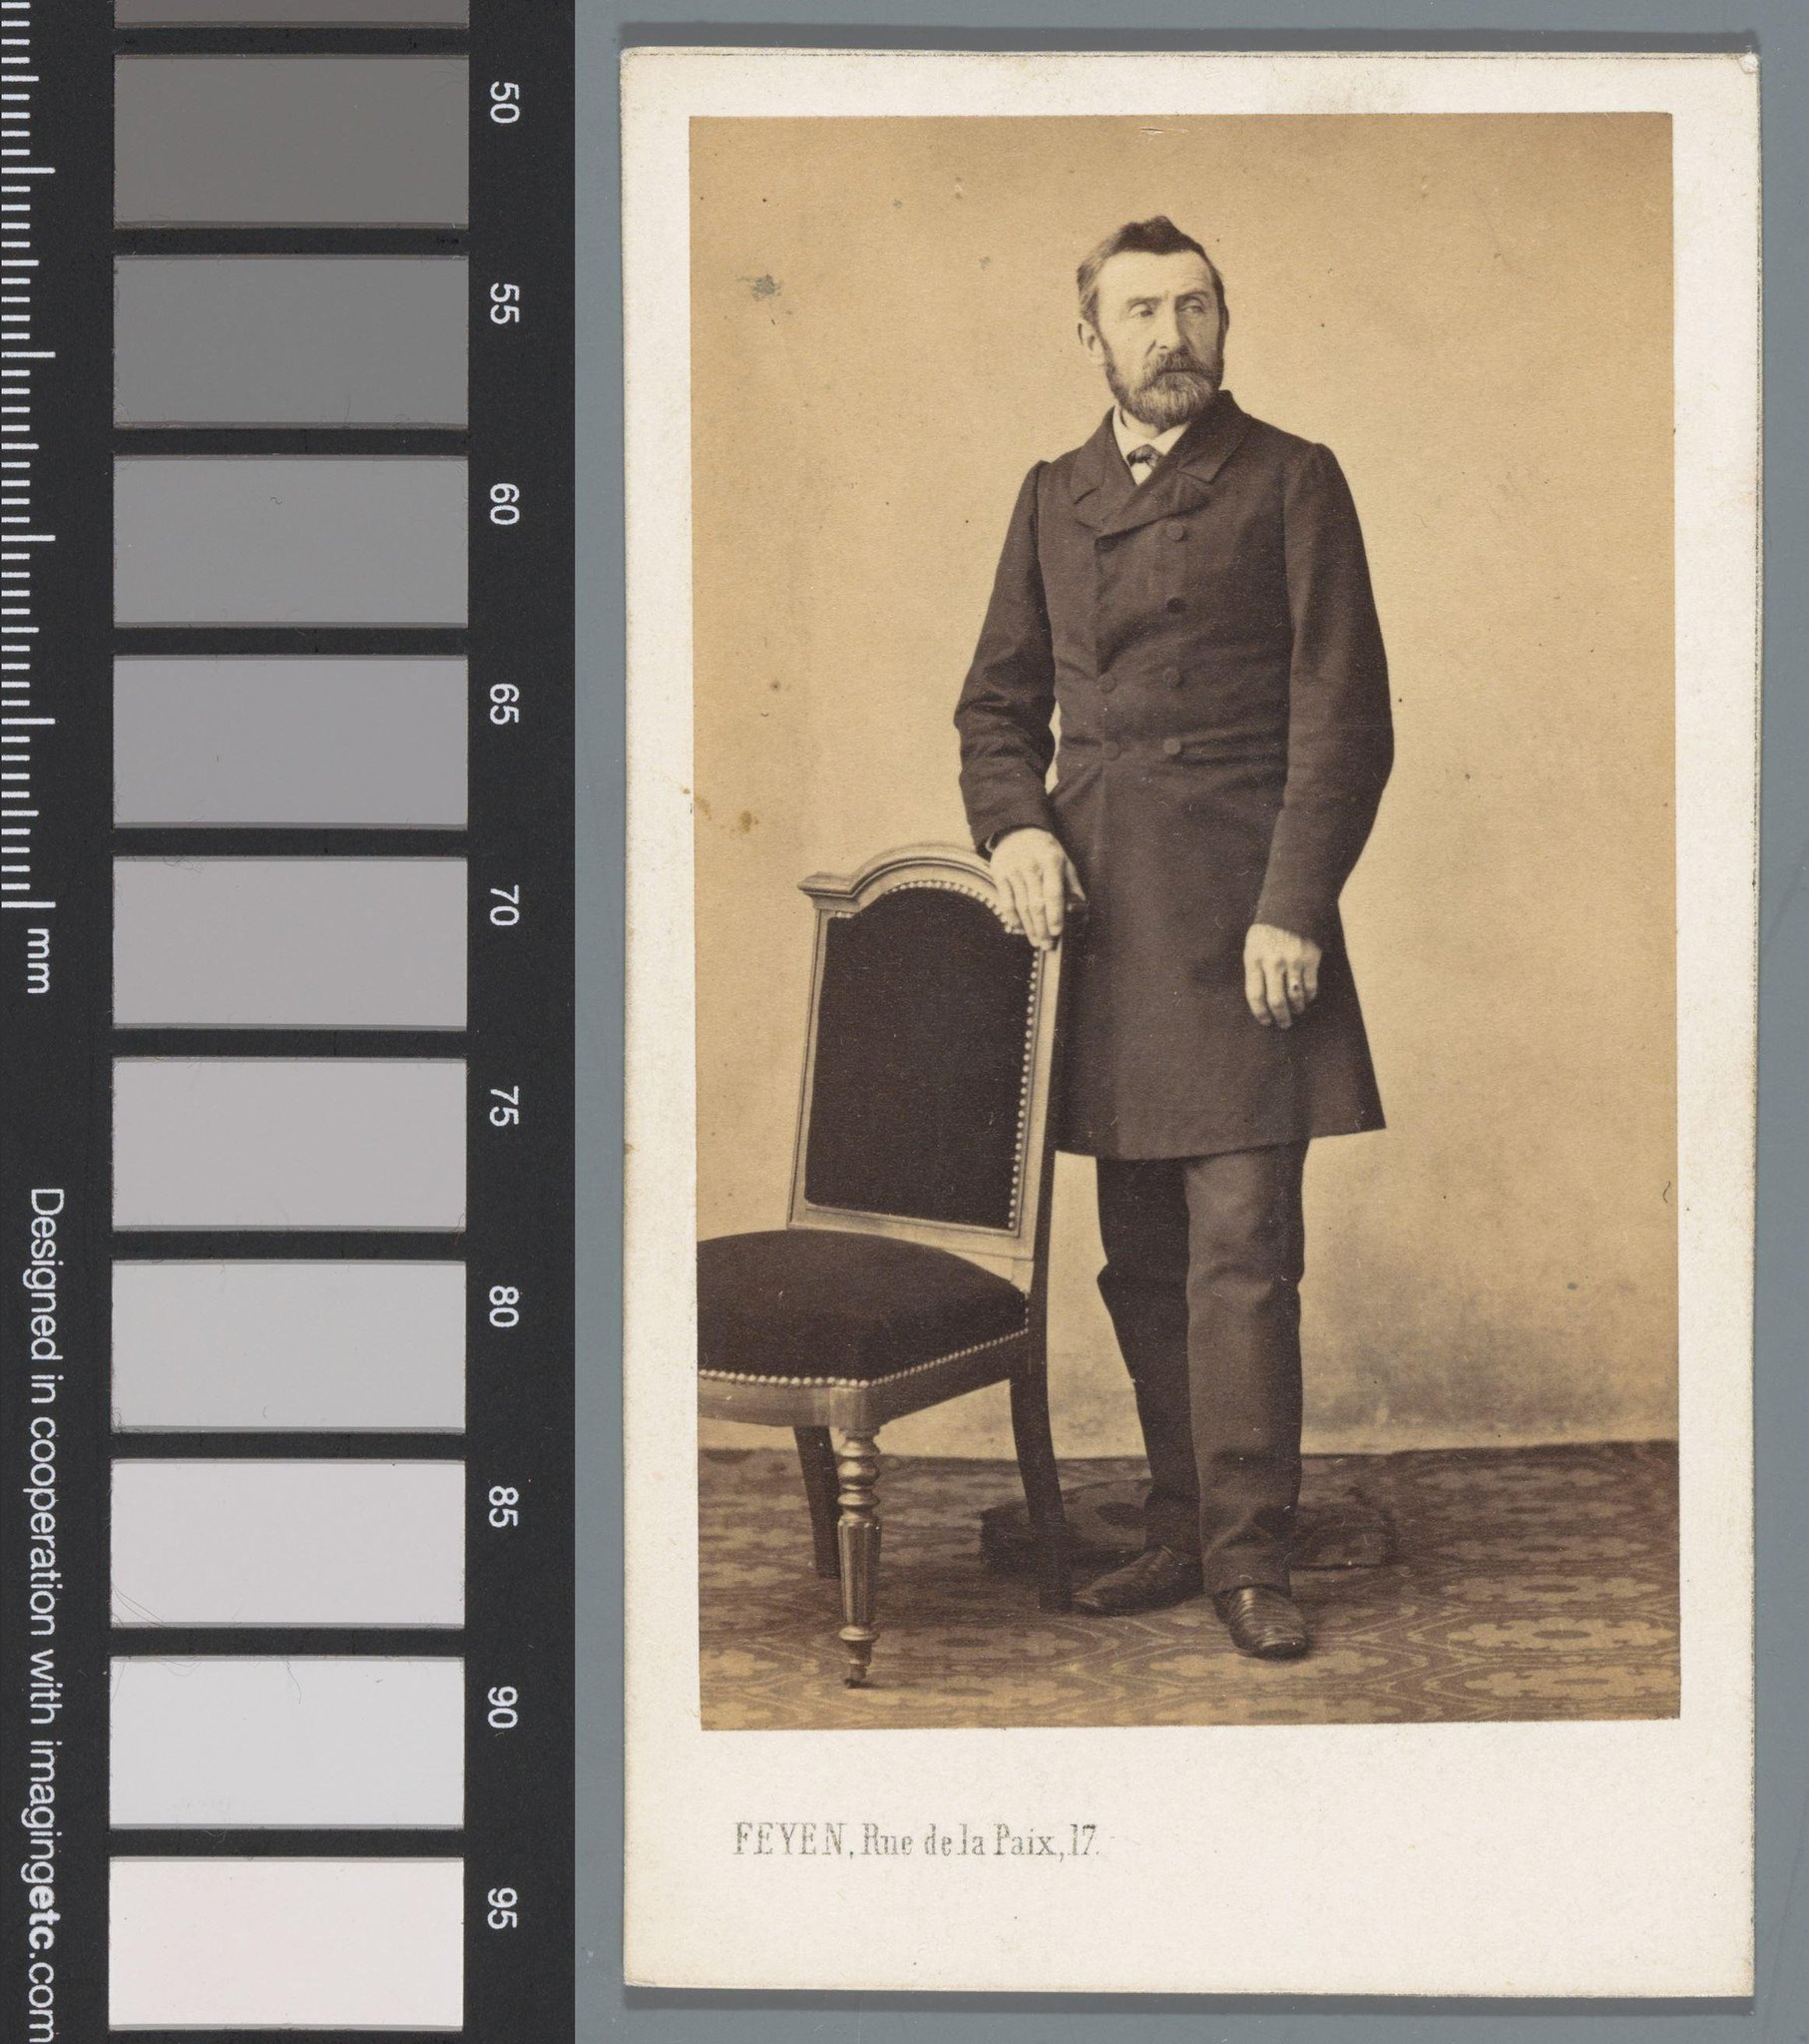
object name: carte de visite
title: Portret van Henri Joseph Harpignies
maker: jacques-eugène feyen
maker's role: painter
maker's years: 1815-1908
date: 1855-1885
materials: cardboard, paper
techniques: albumen print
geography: paris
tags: print maker, draughtsman, henri joseph harpignies, adult man, historical persons, paris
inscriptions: inscription: ‘Feyen. Rue de la Paix, 17.’, inscription: ‘Harpignies’